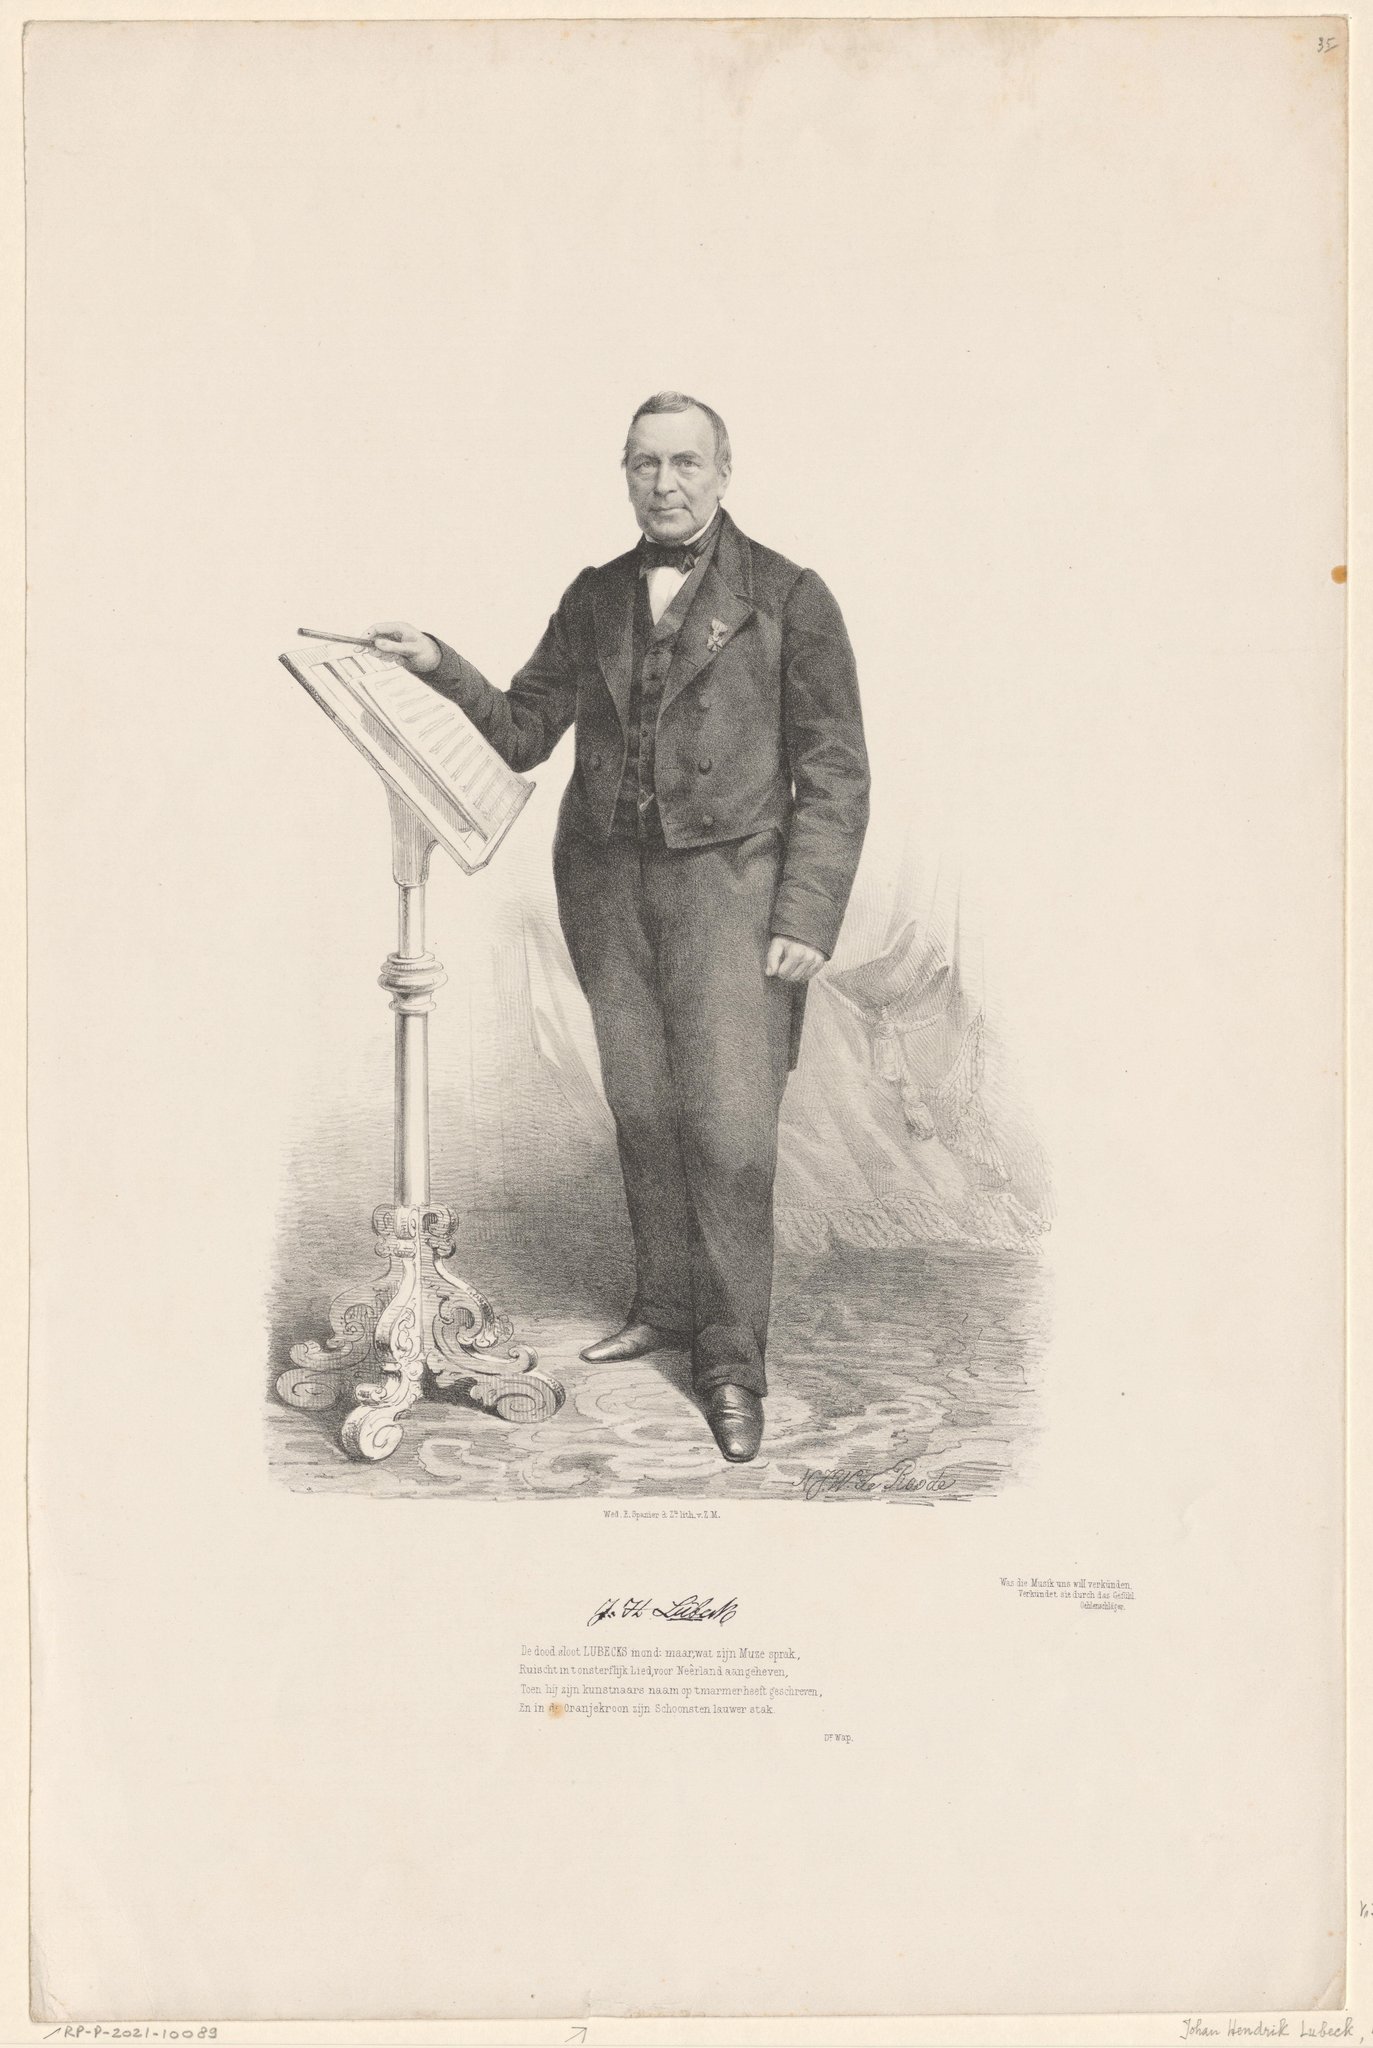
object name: print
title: Portret van Johann Heinrich Lubeck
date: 1865-1883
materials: paper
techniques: lithograph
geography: the hague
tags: the hague, historical persons, portrait of a musician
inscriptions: collector's mark: Lugt 2228